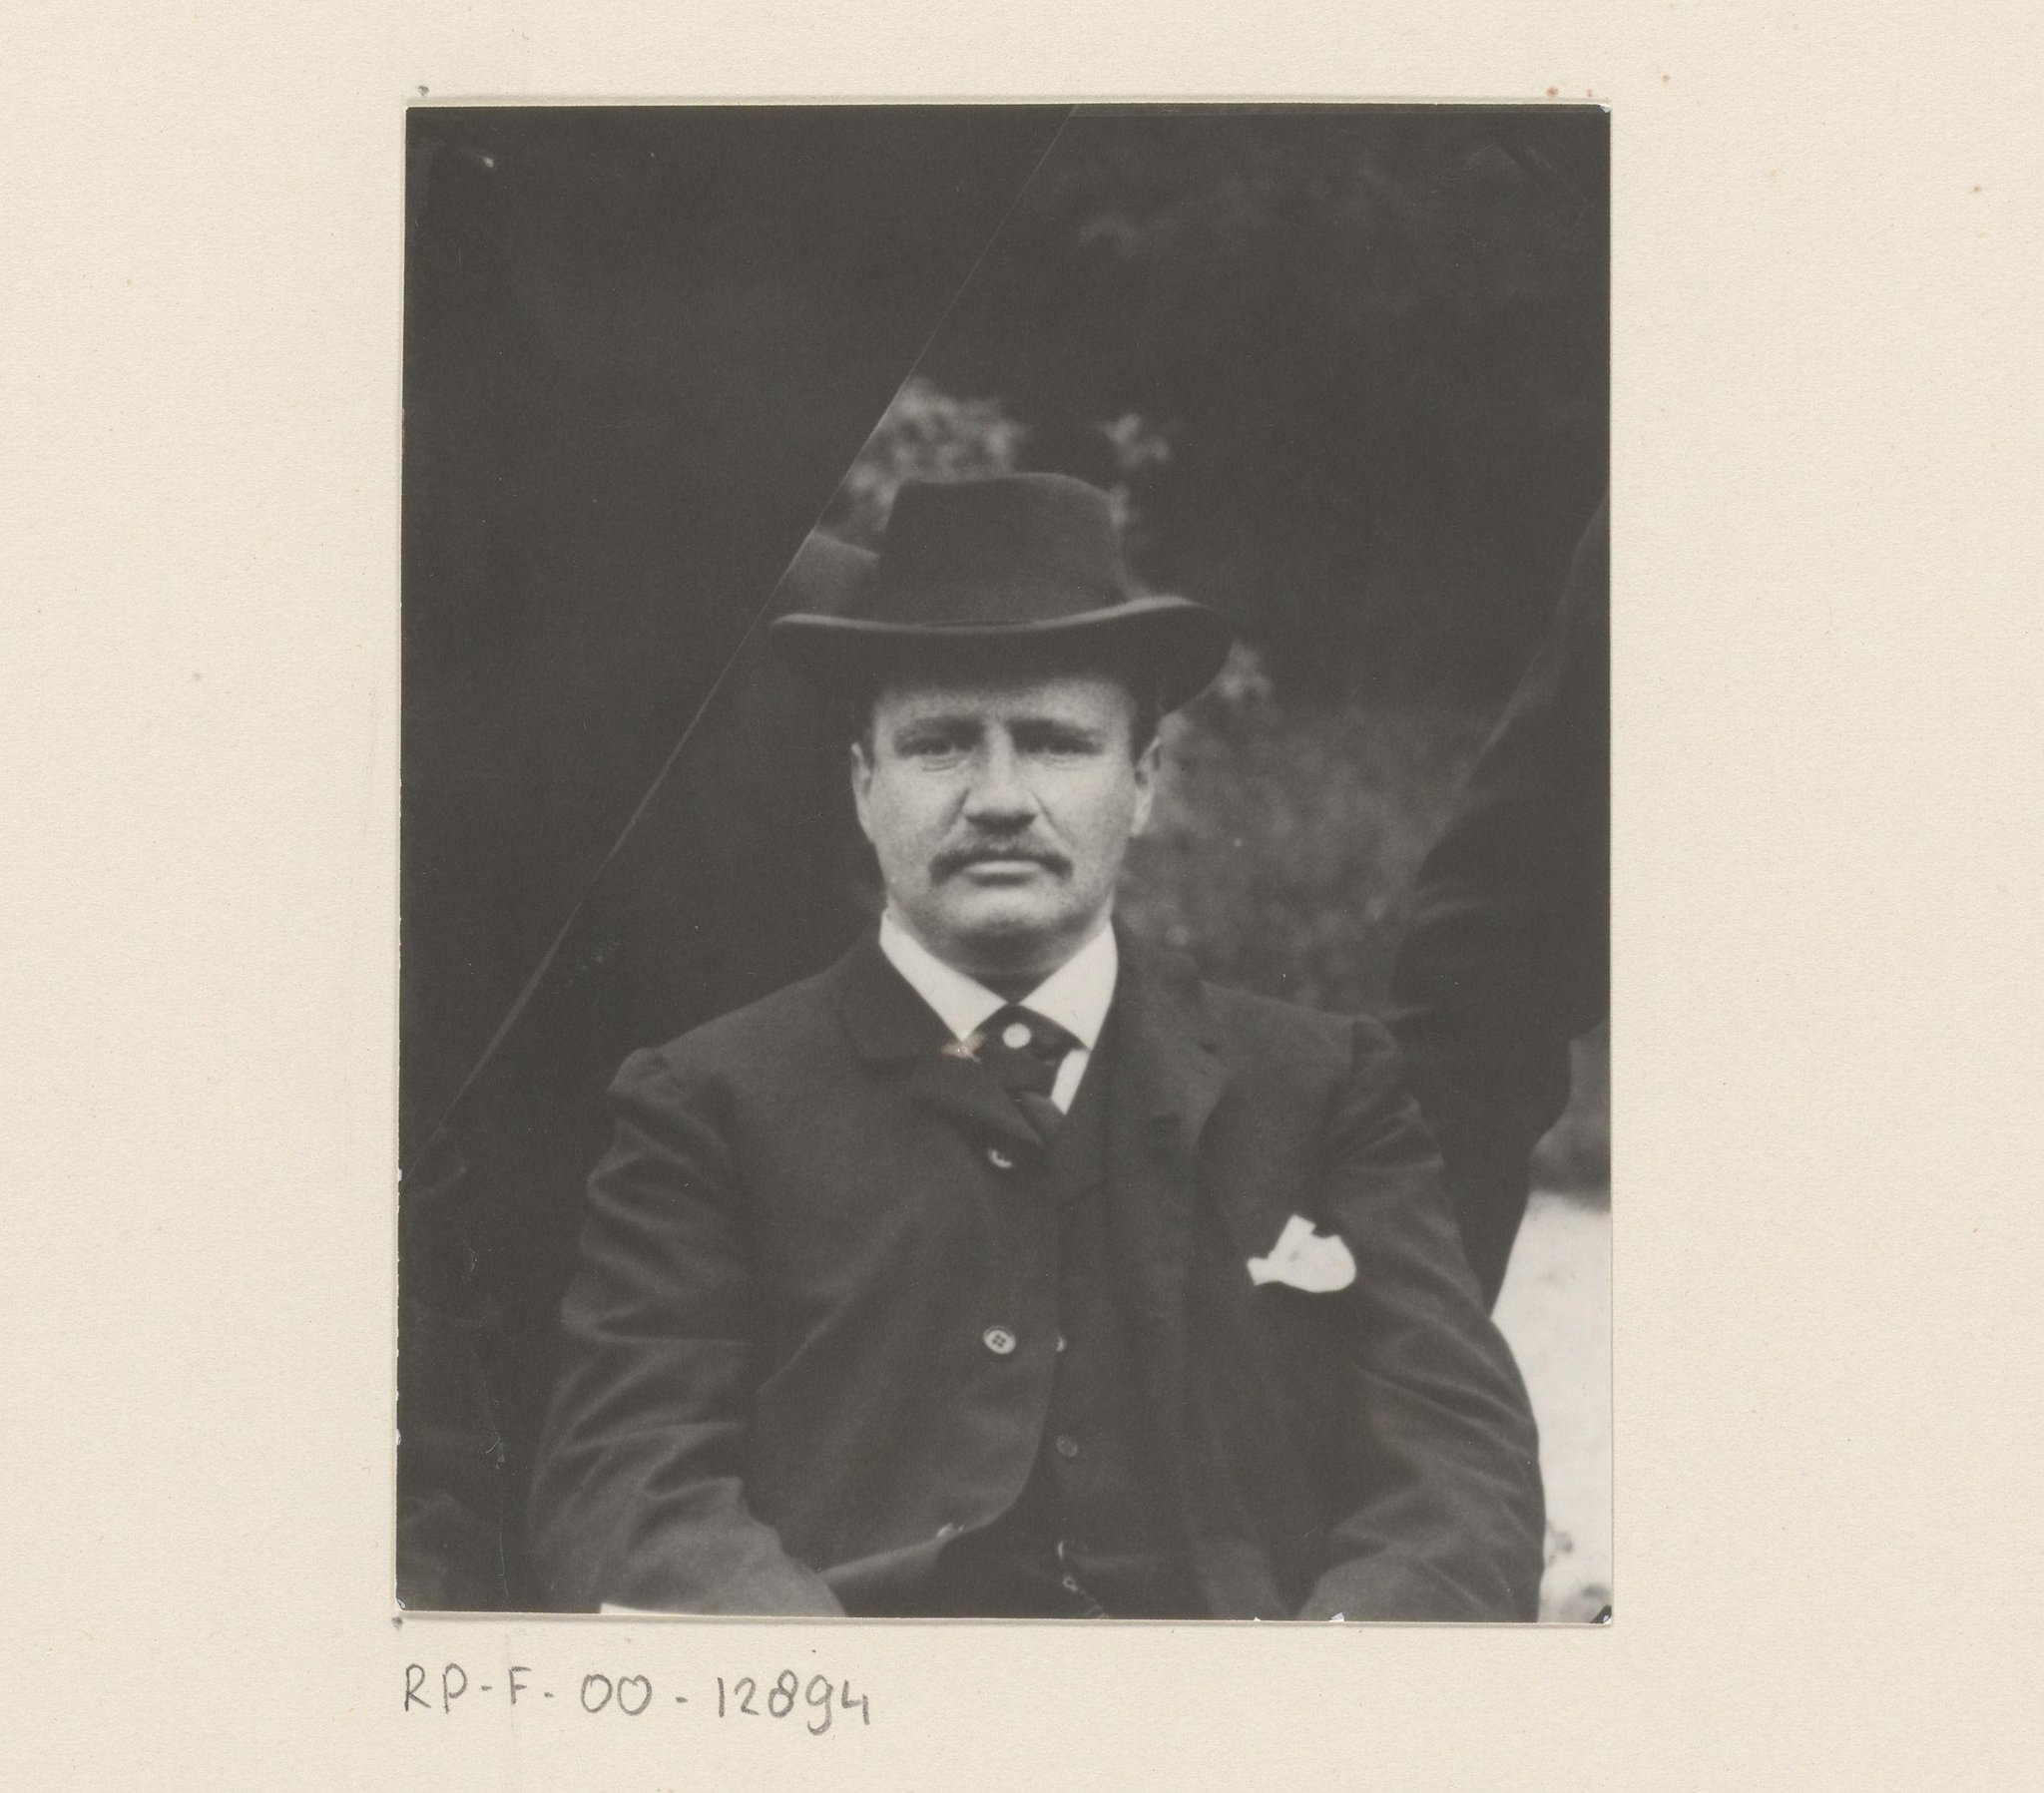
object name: photograph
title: Portret van Adriaan Goekoop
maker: Anonymous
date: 1900-1914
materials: paper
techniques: gelatin silver print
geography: the hague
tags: the hague, art (+ relief ~ sculpture), writer, poet, author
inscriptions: inscription: ‘AEH Goekoop/ D Hage/ + 1914’